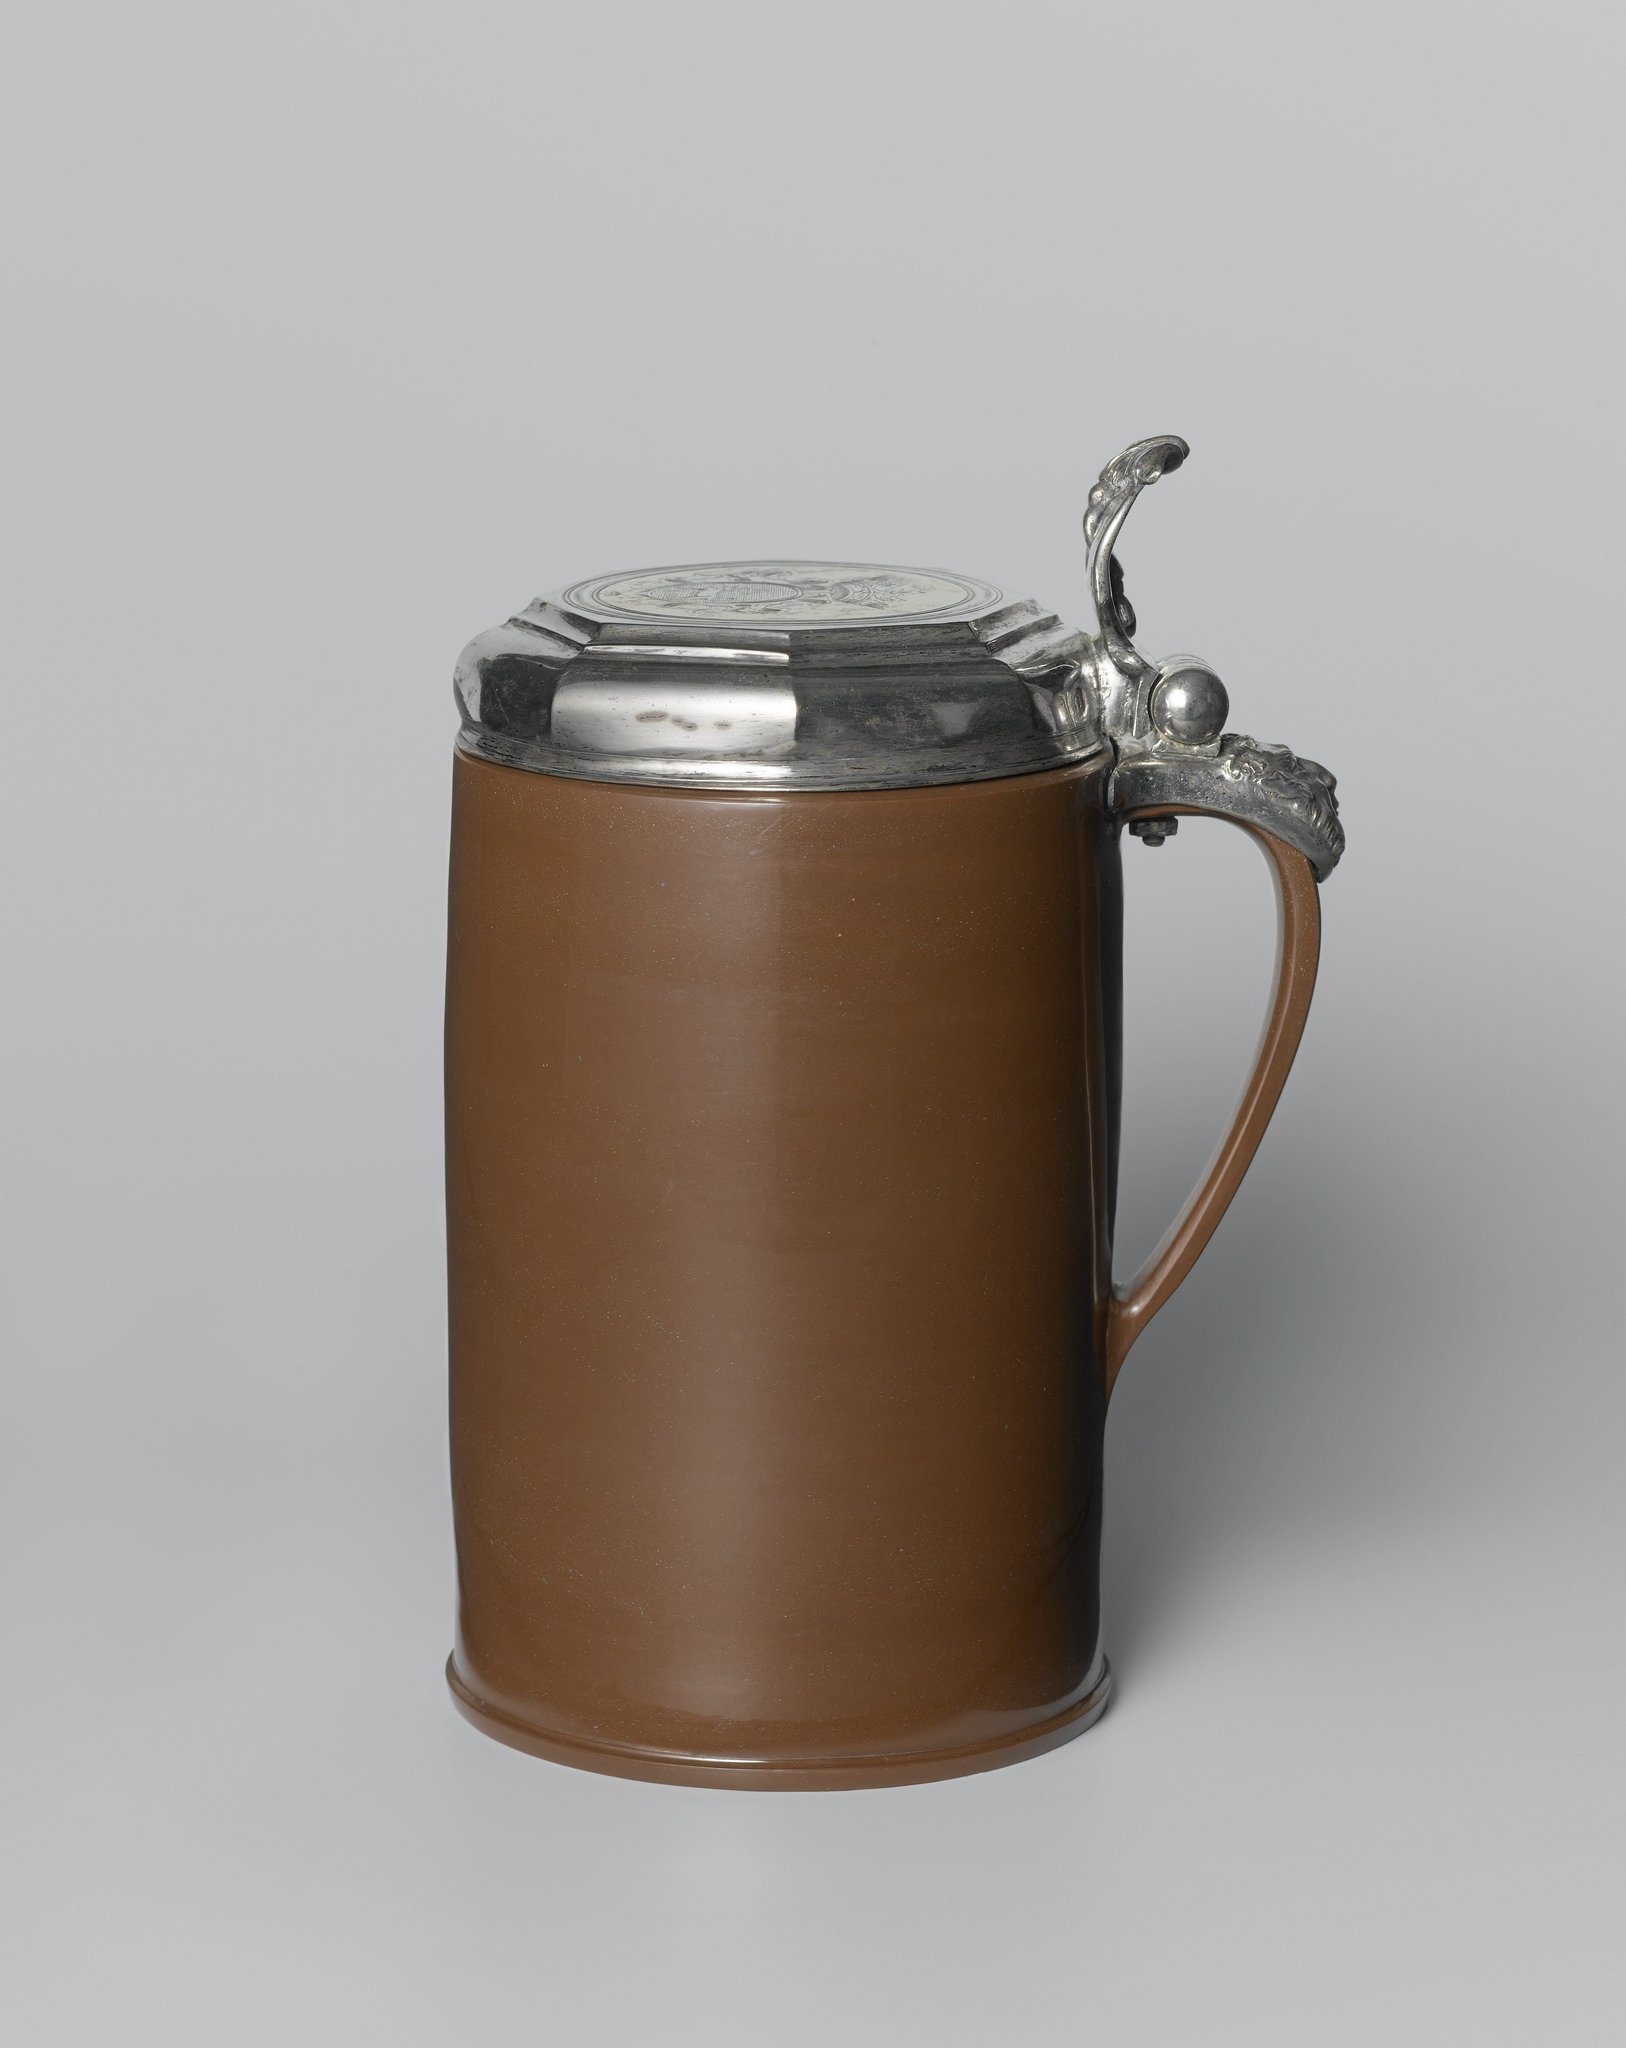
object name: eating drinking utensil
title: Tankard with the arms of the Von Hundt von Alten-Grottkau family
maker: Anonymous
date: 1716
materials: silver, stoneware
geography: meissen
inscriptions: town mark, date letter: ‘P’, maker's mark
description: Meissener Porzellan Manufaktur Meissen, c. 1715 lid: Dresden, 1716 stoneware, silver